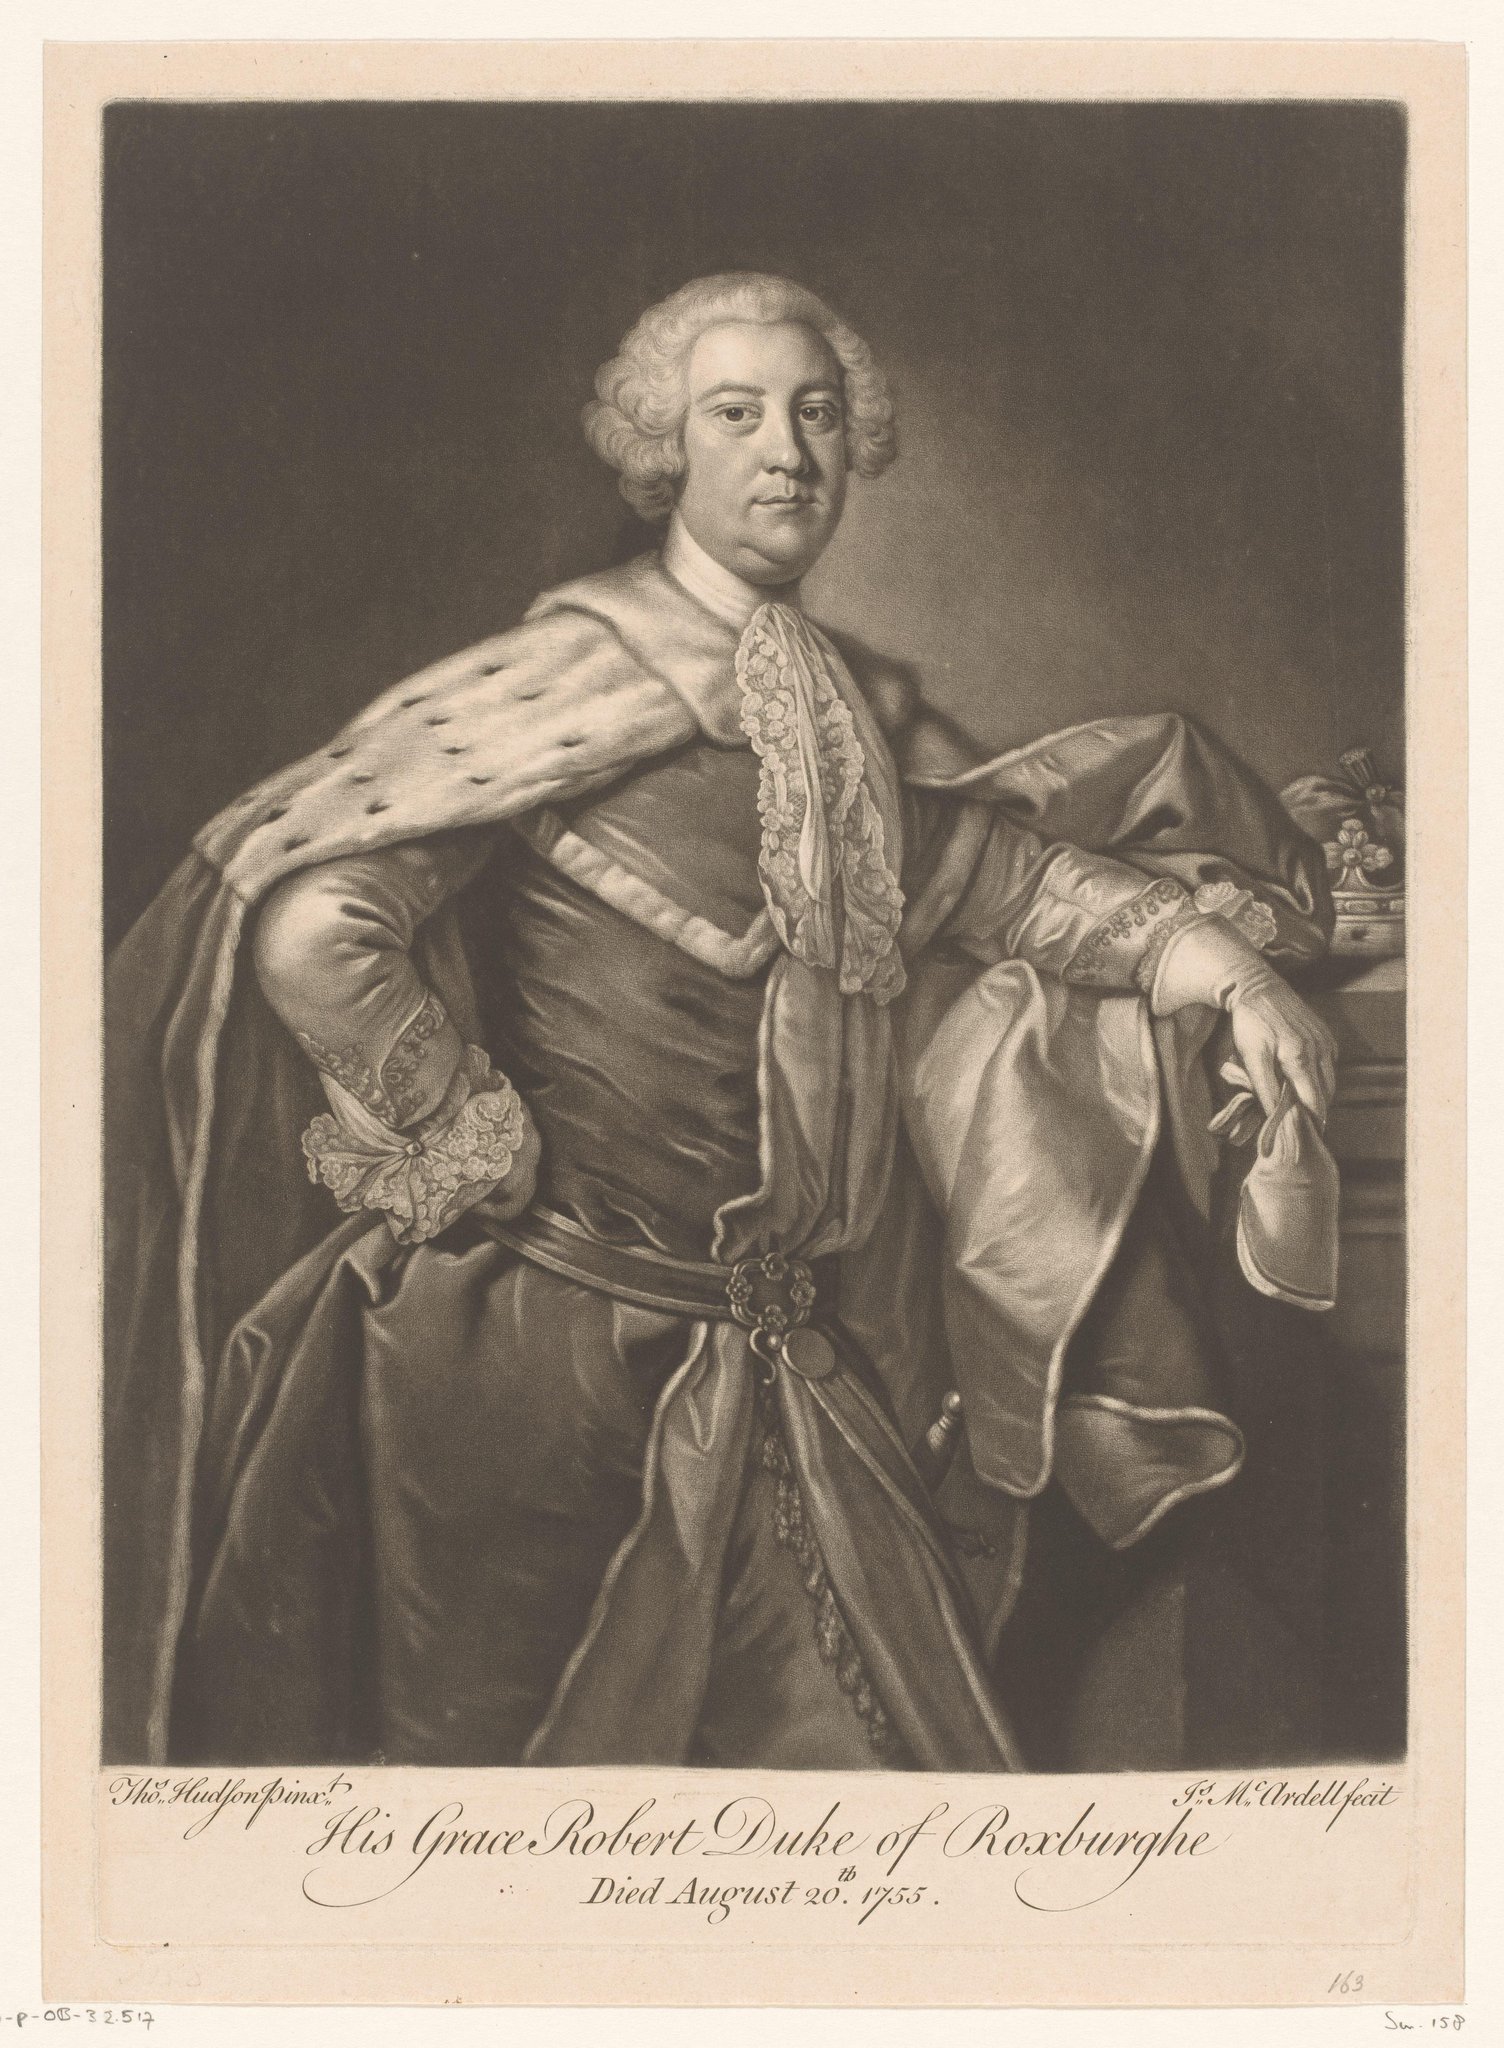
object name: print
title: His Grace Robert Duke of Roxburghe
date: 1755-1765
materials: paper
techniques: mezzotint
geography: london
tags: historical persons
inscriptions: collector's mark: Lugt 240